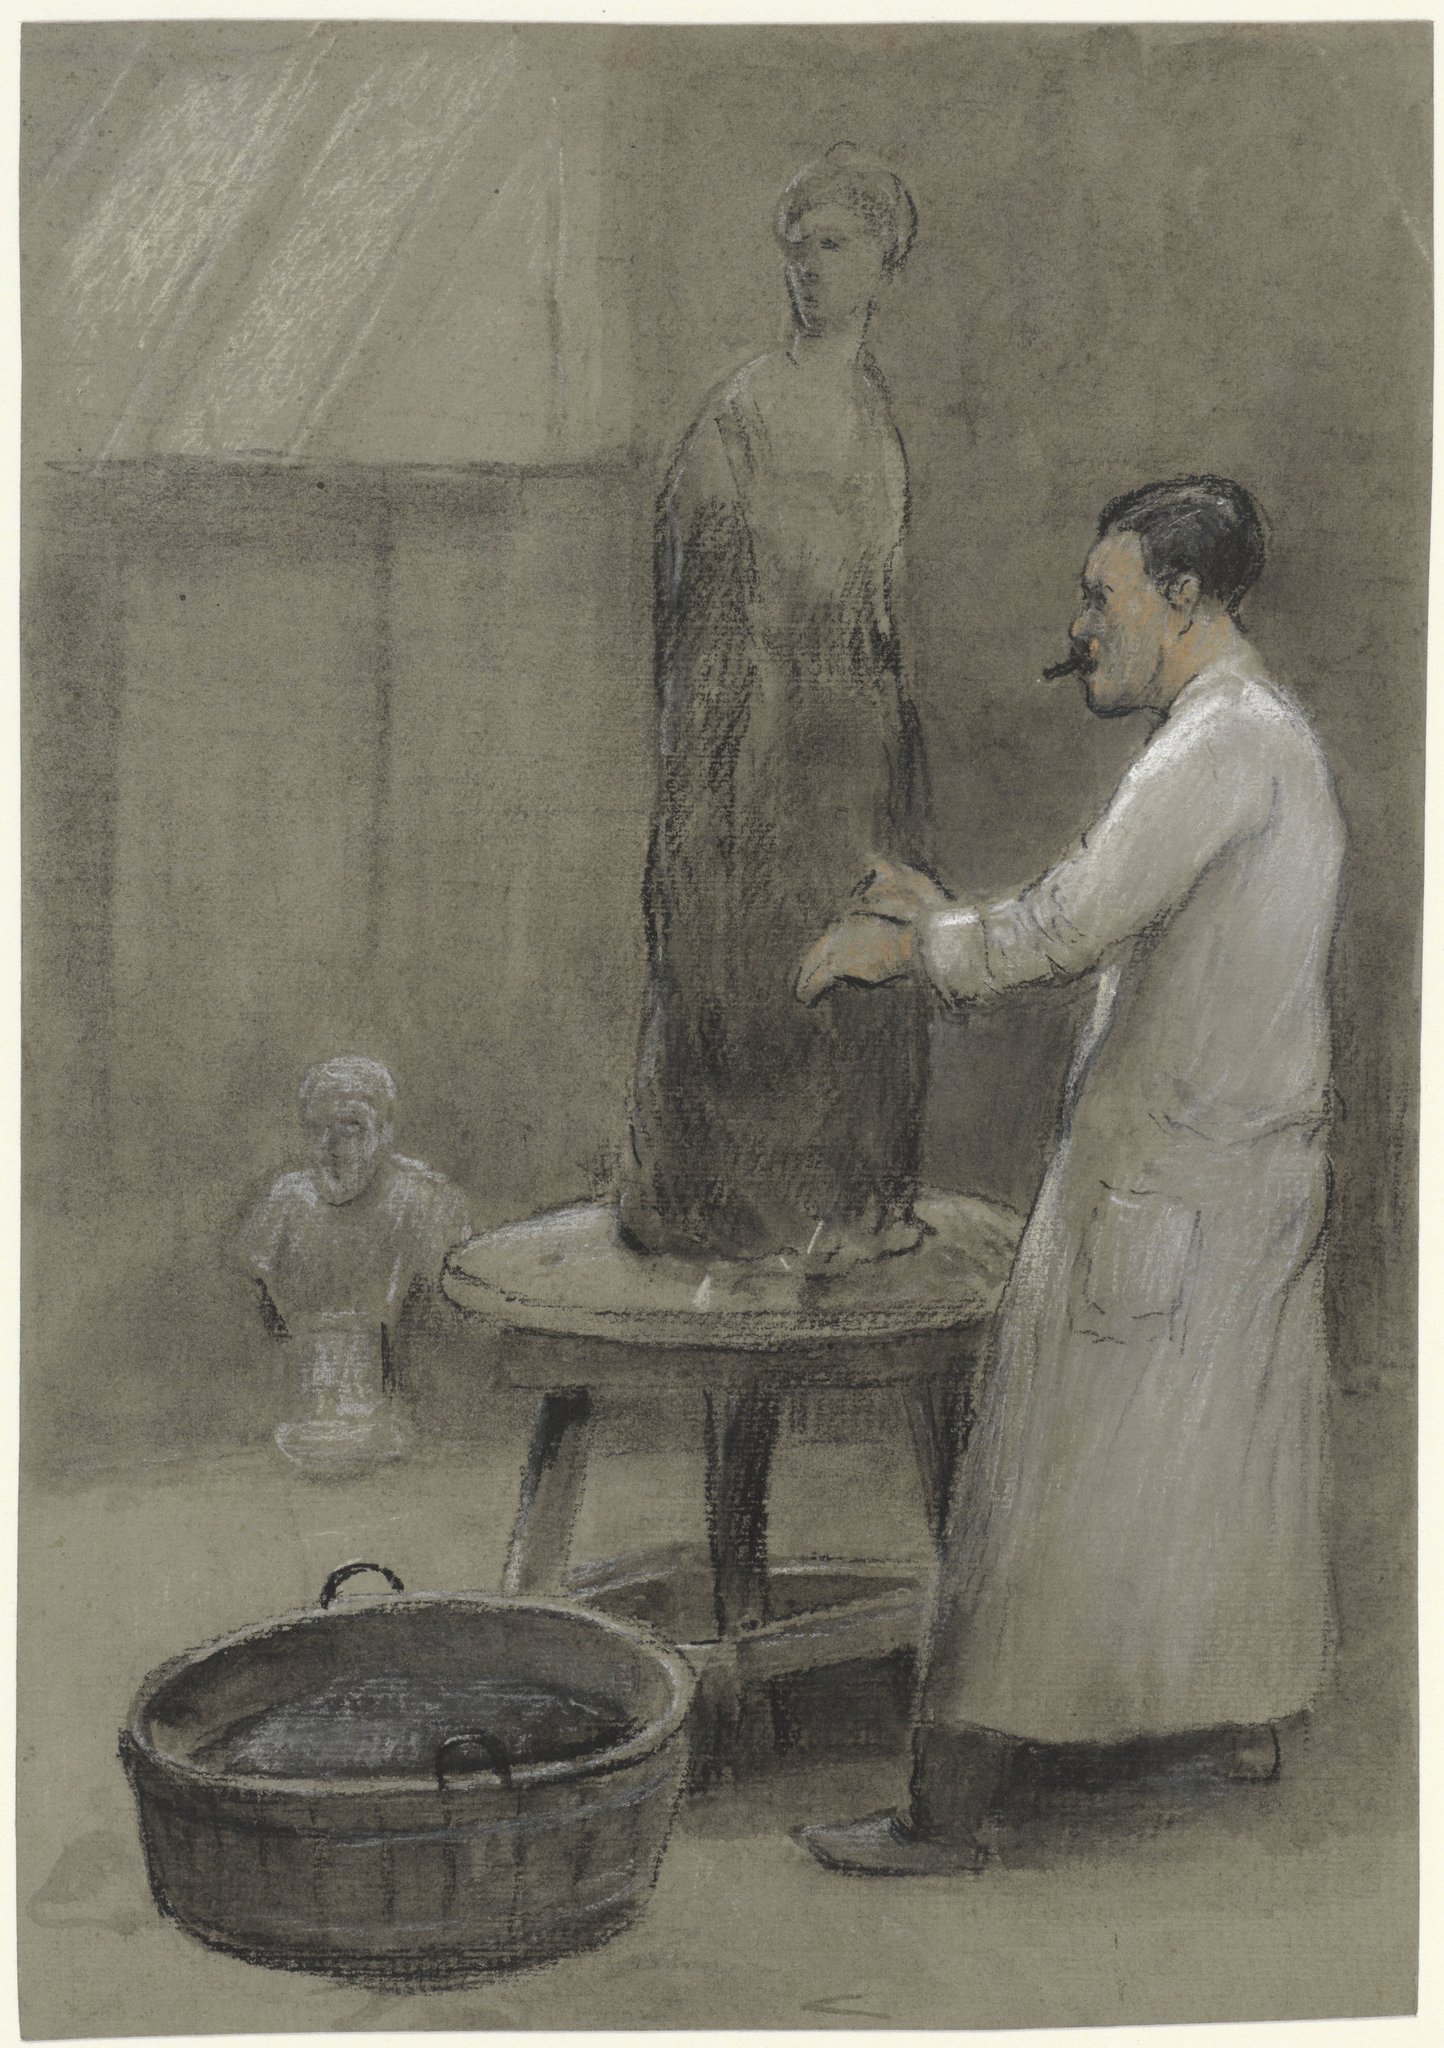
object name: drawing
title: Beeldhouwer en zijn beeld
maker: herman heijenbrock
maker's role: draughtsman, painter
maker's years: 1871-1948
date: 1881-1948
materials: chalk, paper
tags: sculptor at work